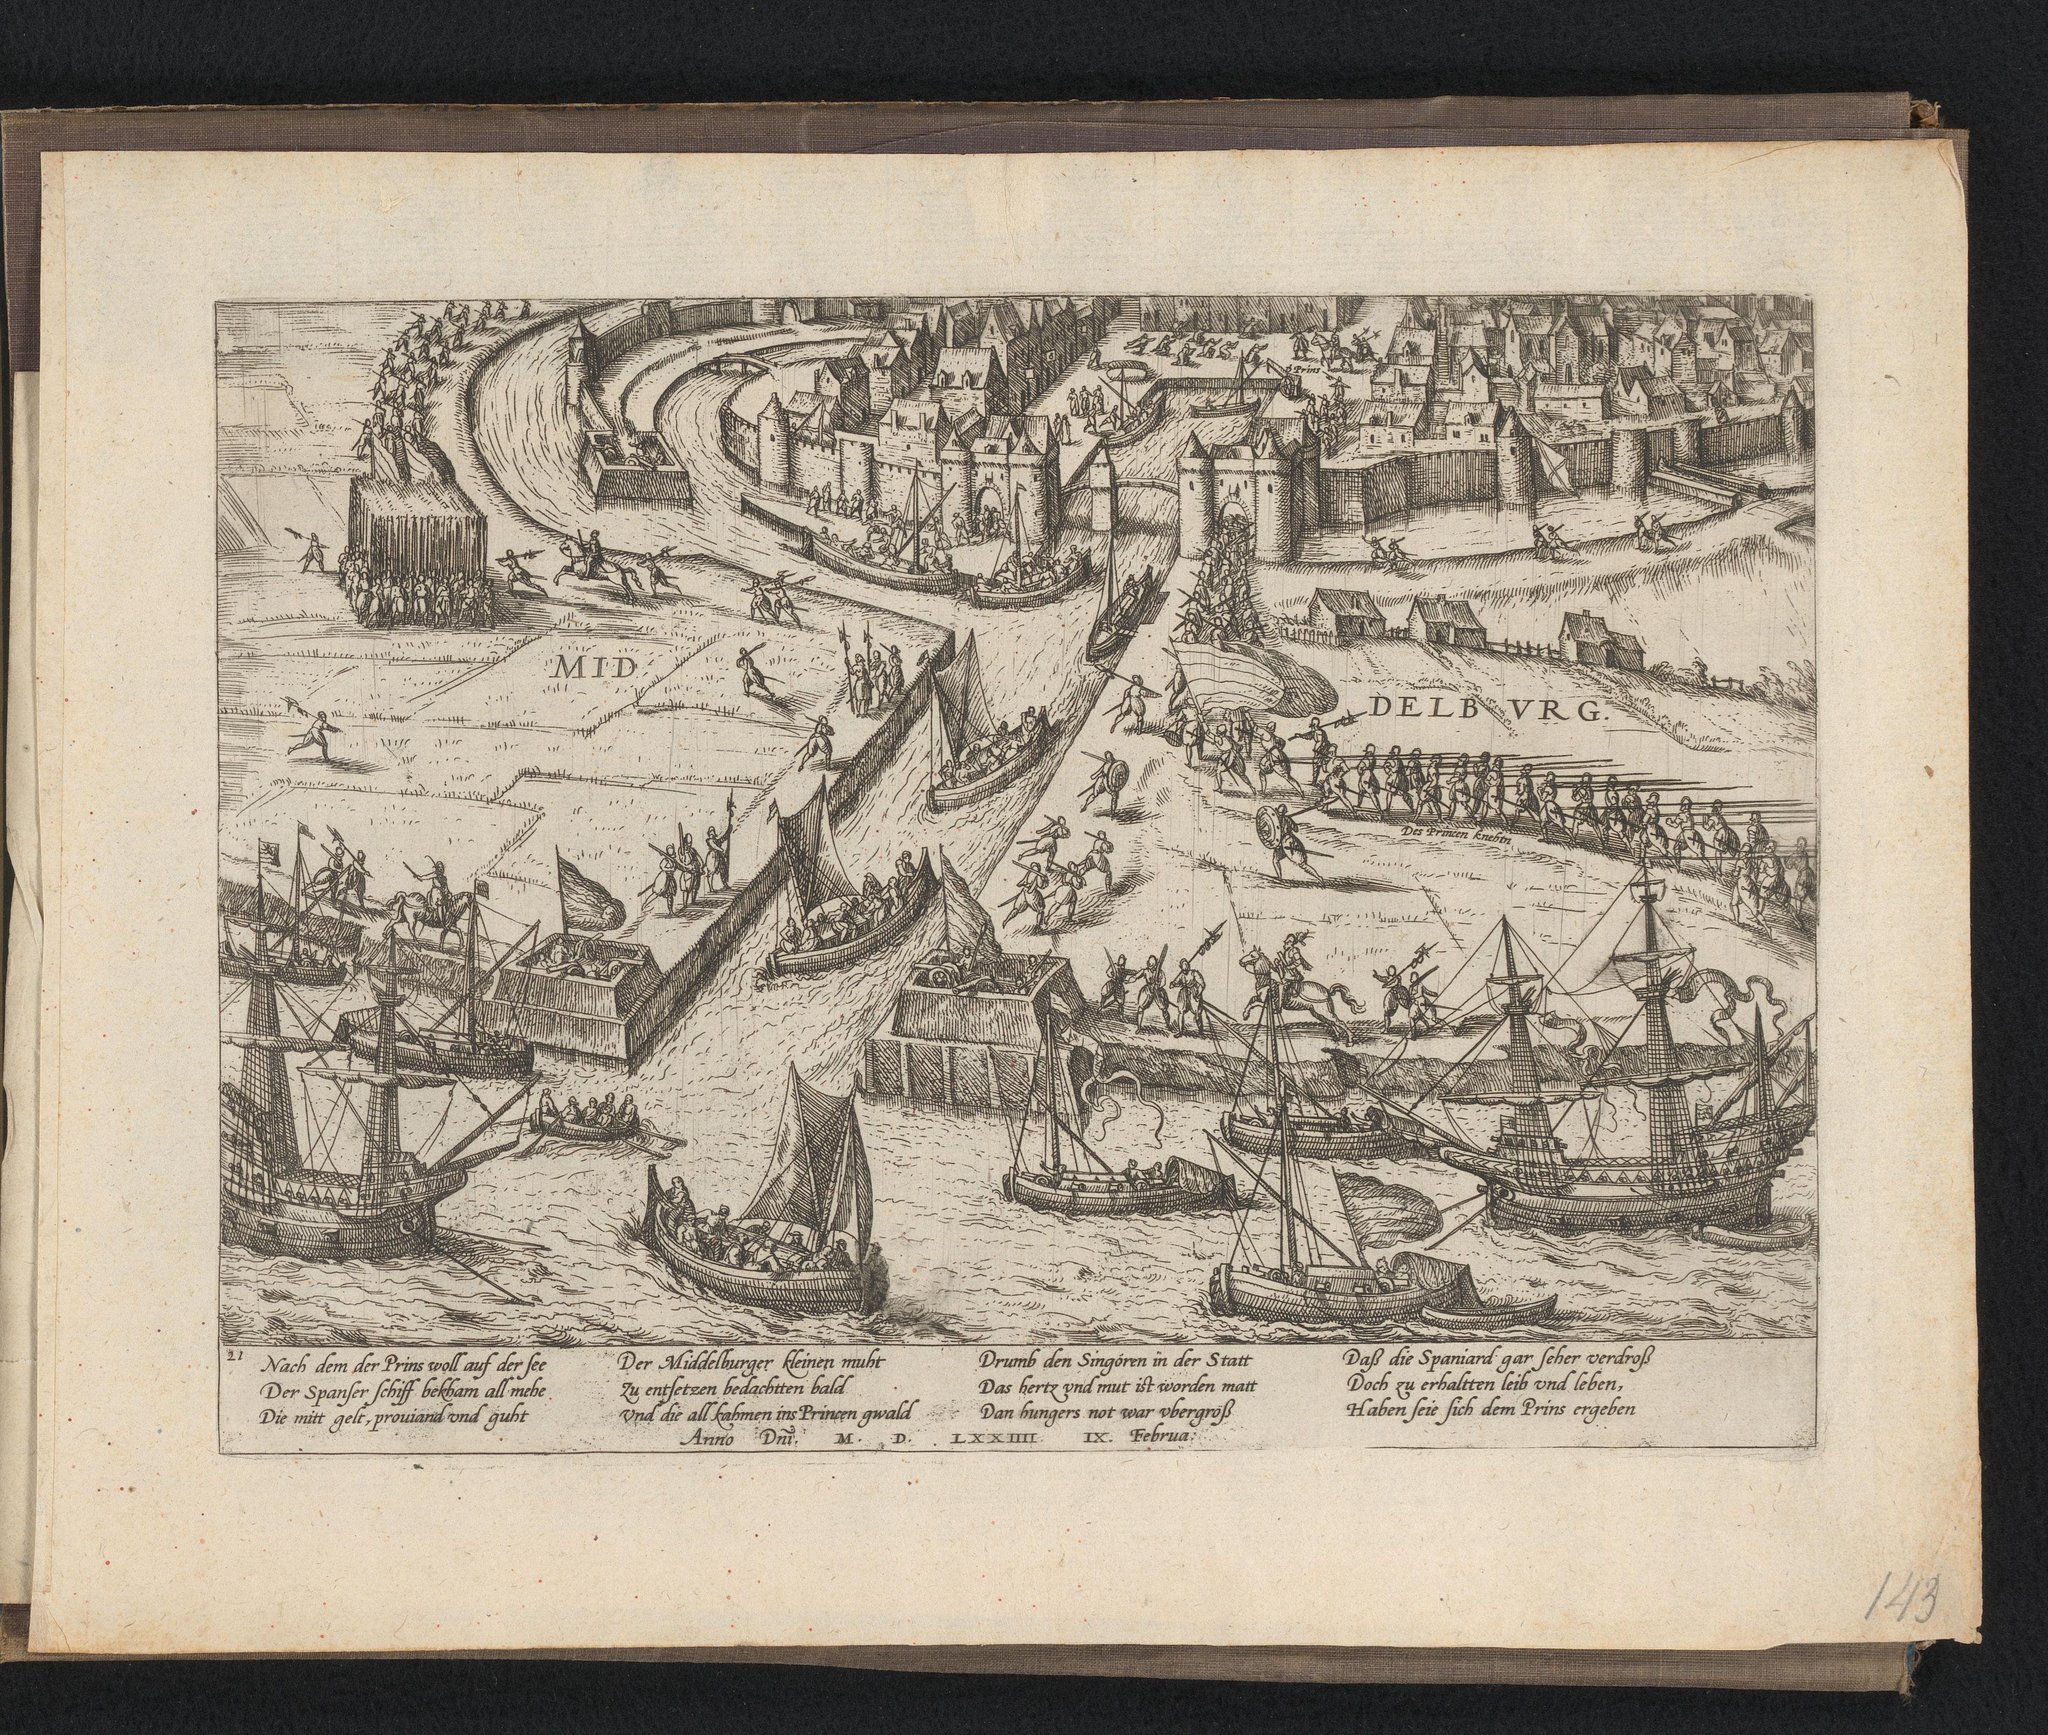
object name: print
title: Capitulatie van Middelburg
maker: frans hogenberg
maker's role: print maker, publisher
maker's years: 1538-1590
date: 1574-1583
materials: paper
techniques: etching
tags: delft, william i (prince of orange), capture of city (after the siege), middelburg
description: Prent gebruikt in: Aitsinger, Michael. De Leone Belgico ejusque topographica atque historica descriptione liber (...). S.l.s.n., 1583.